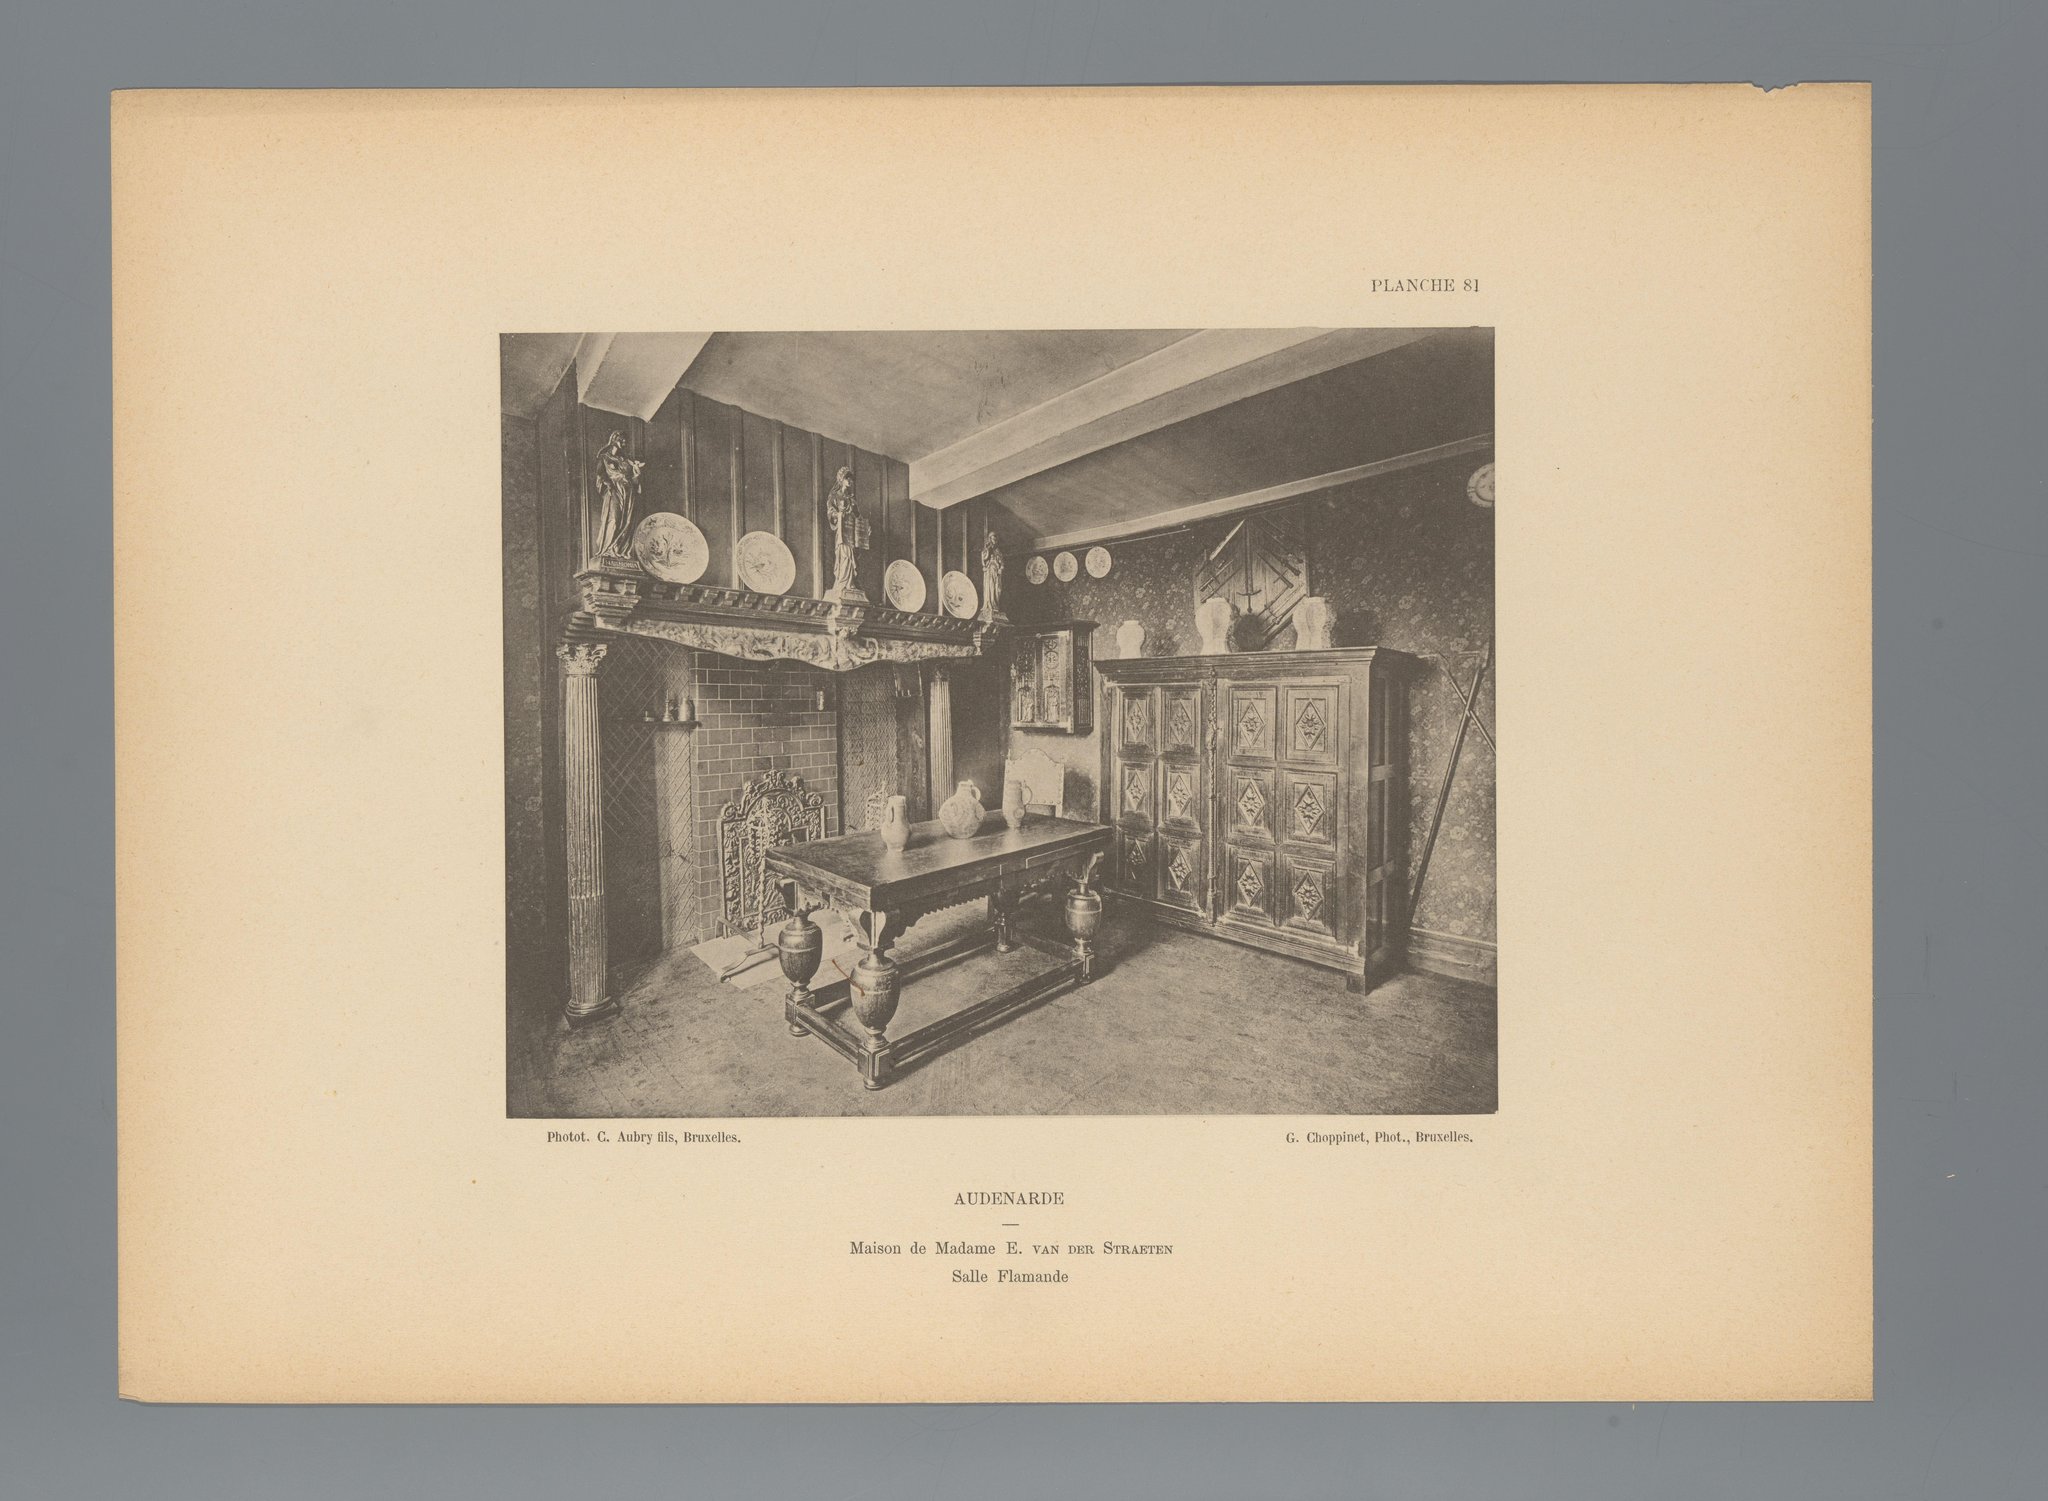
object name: photomechanical print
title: Gezicht op een zaal in Vlaamse stijl in het huis van E. van der Straeten in Oudenaarde, België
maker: gustave choppinet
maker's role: fotograaf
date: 1893-1898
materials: paper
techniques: photograph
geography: brussels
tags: interior of the house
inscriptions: inscription: ‘Maison de Madame E. van der Straeten/ Salle Flamande’, number: ‘PLANCHE 81’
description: Deze prent maakt deel uit van een omslag met 89 prenten en 5 tekstbladen.